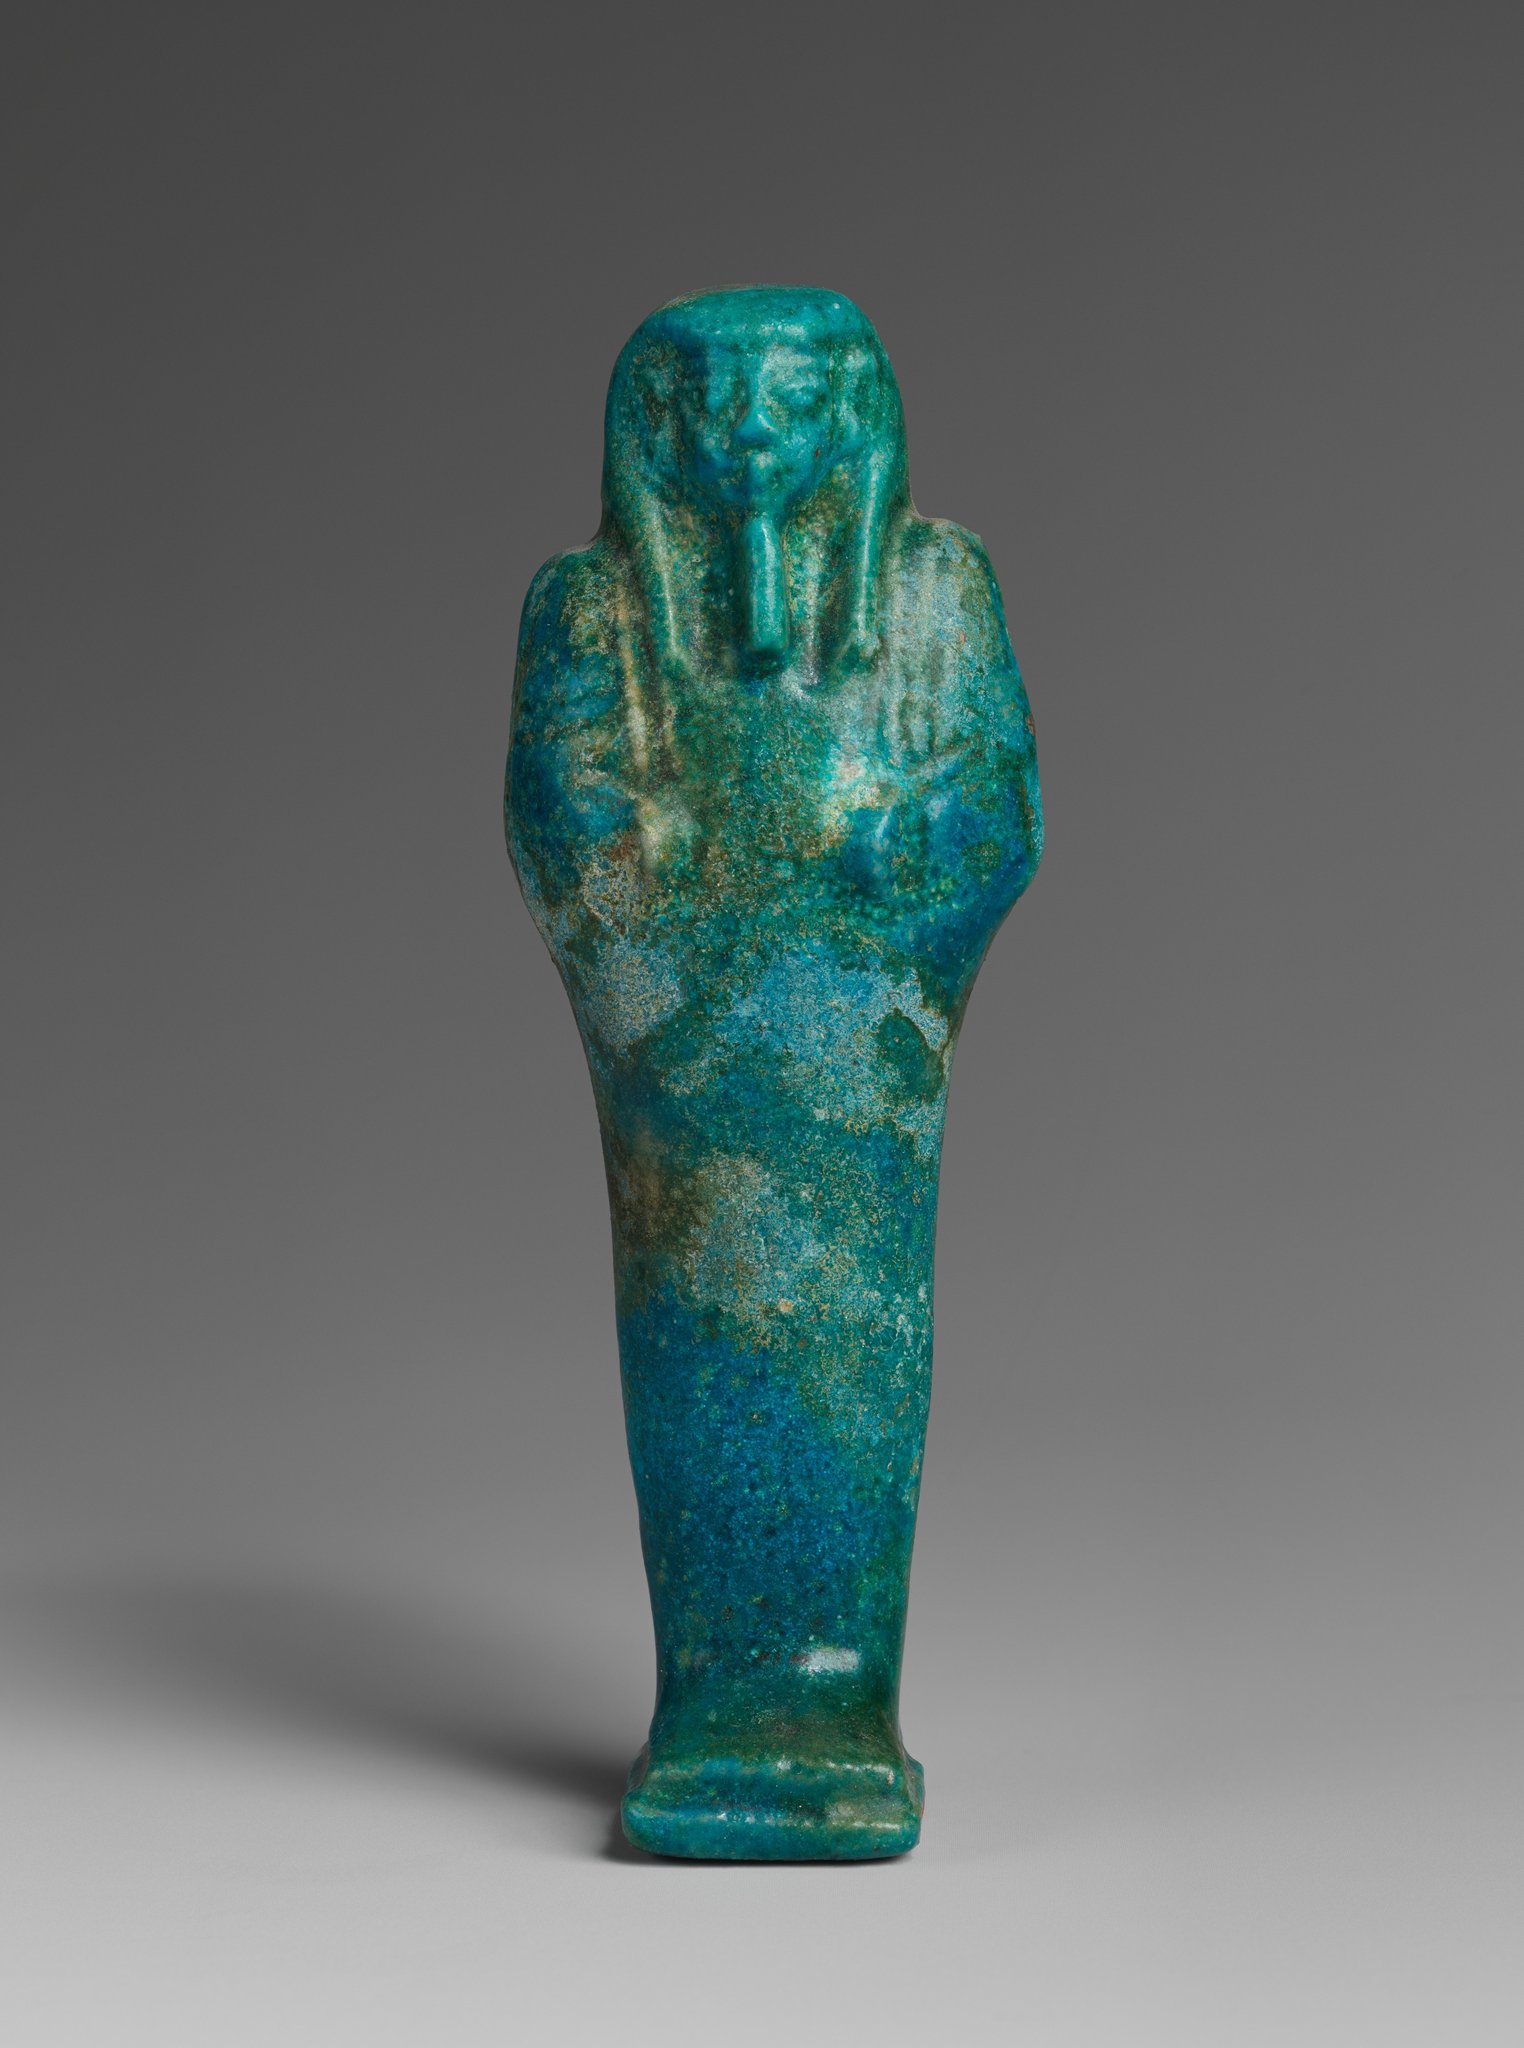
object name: shabti, djedhor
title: Shabti of Djedhor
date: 360-300 BCE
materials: faience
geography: egypt